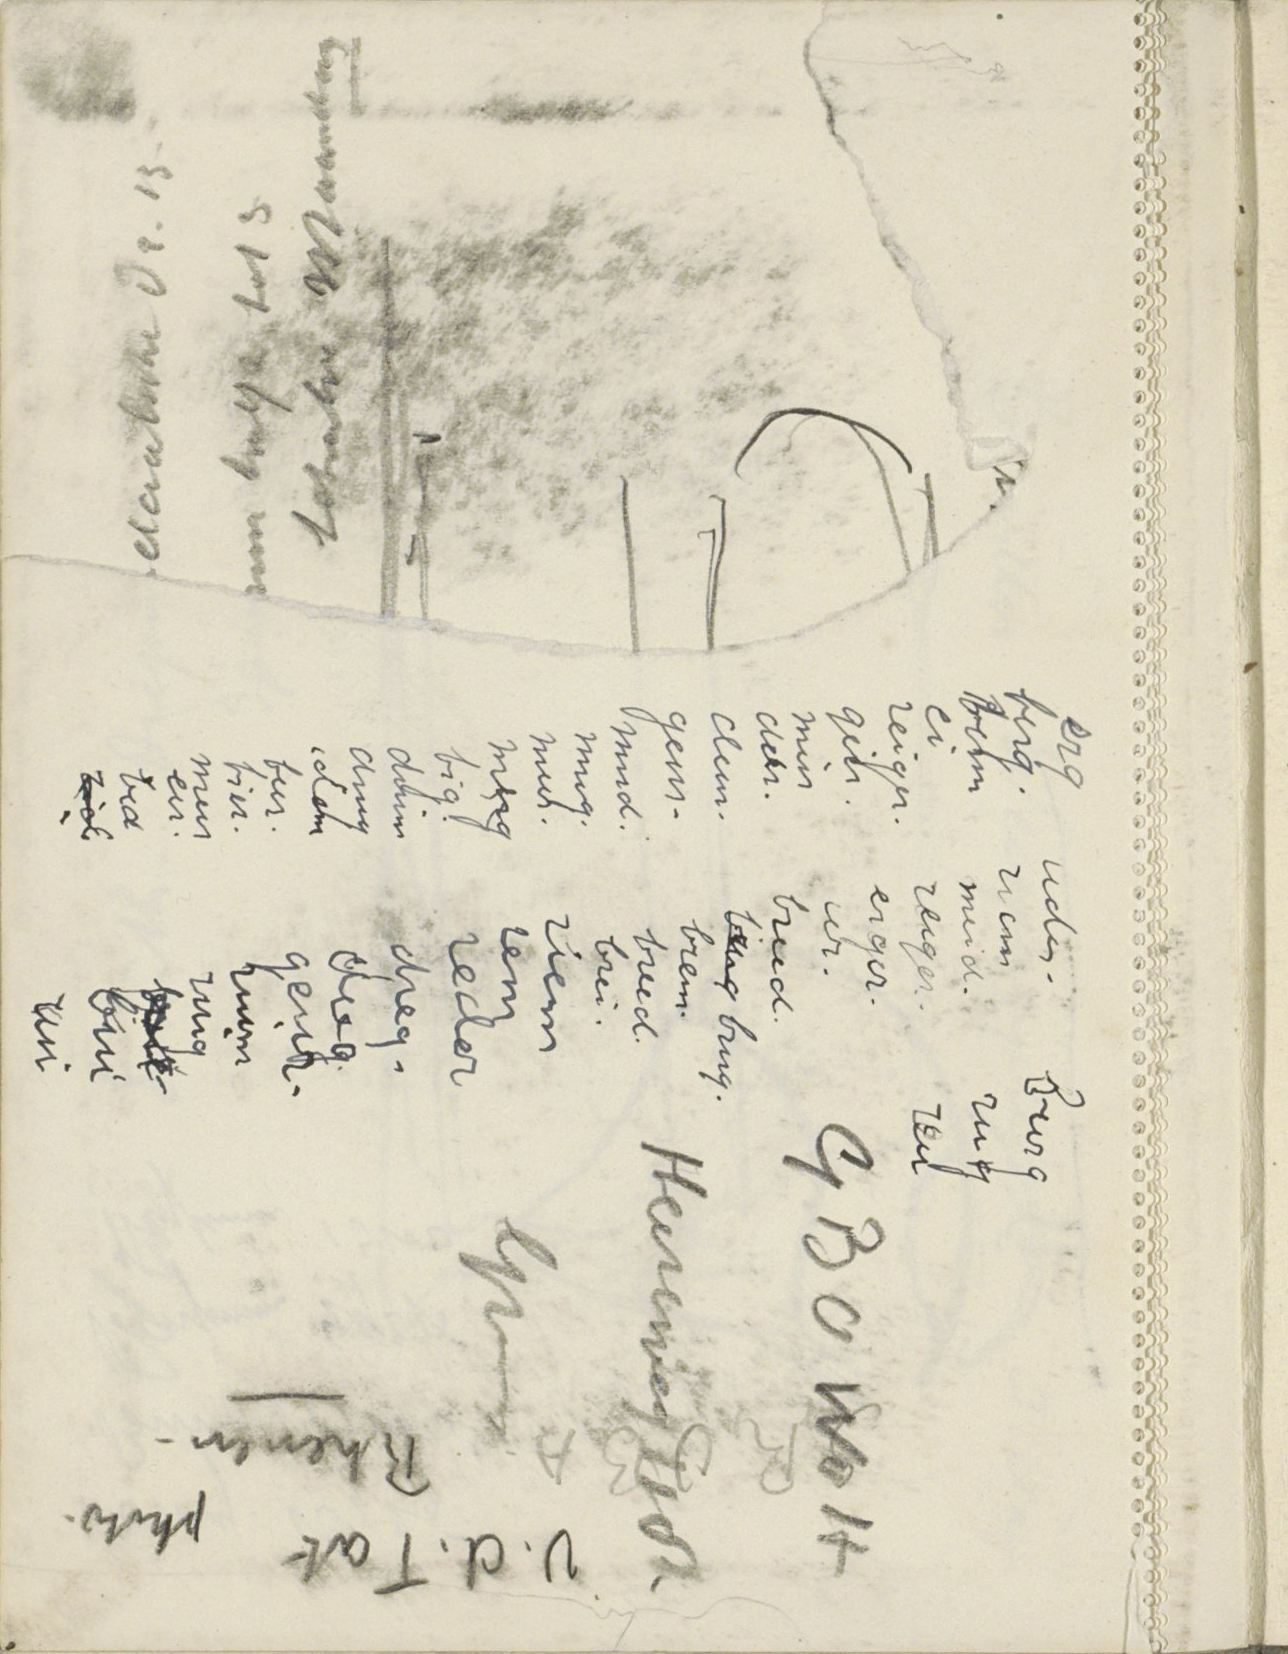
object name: sketchbook leaf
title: Notities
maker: cornelis vreedenburgh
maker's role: draughtsman, print maker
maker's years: 1880-1946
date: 1890-1946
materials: ink, paper, pencil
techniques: pen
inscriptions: annotation: ‘[...]’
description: Blad 71 verso uit een schetsboek met 71 bladen.